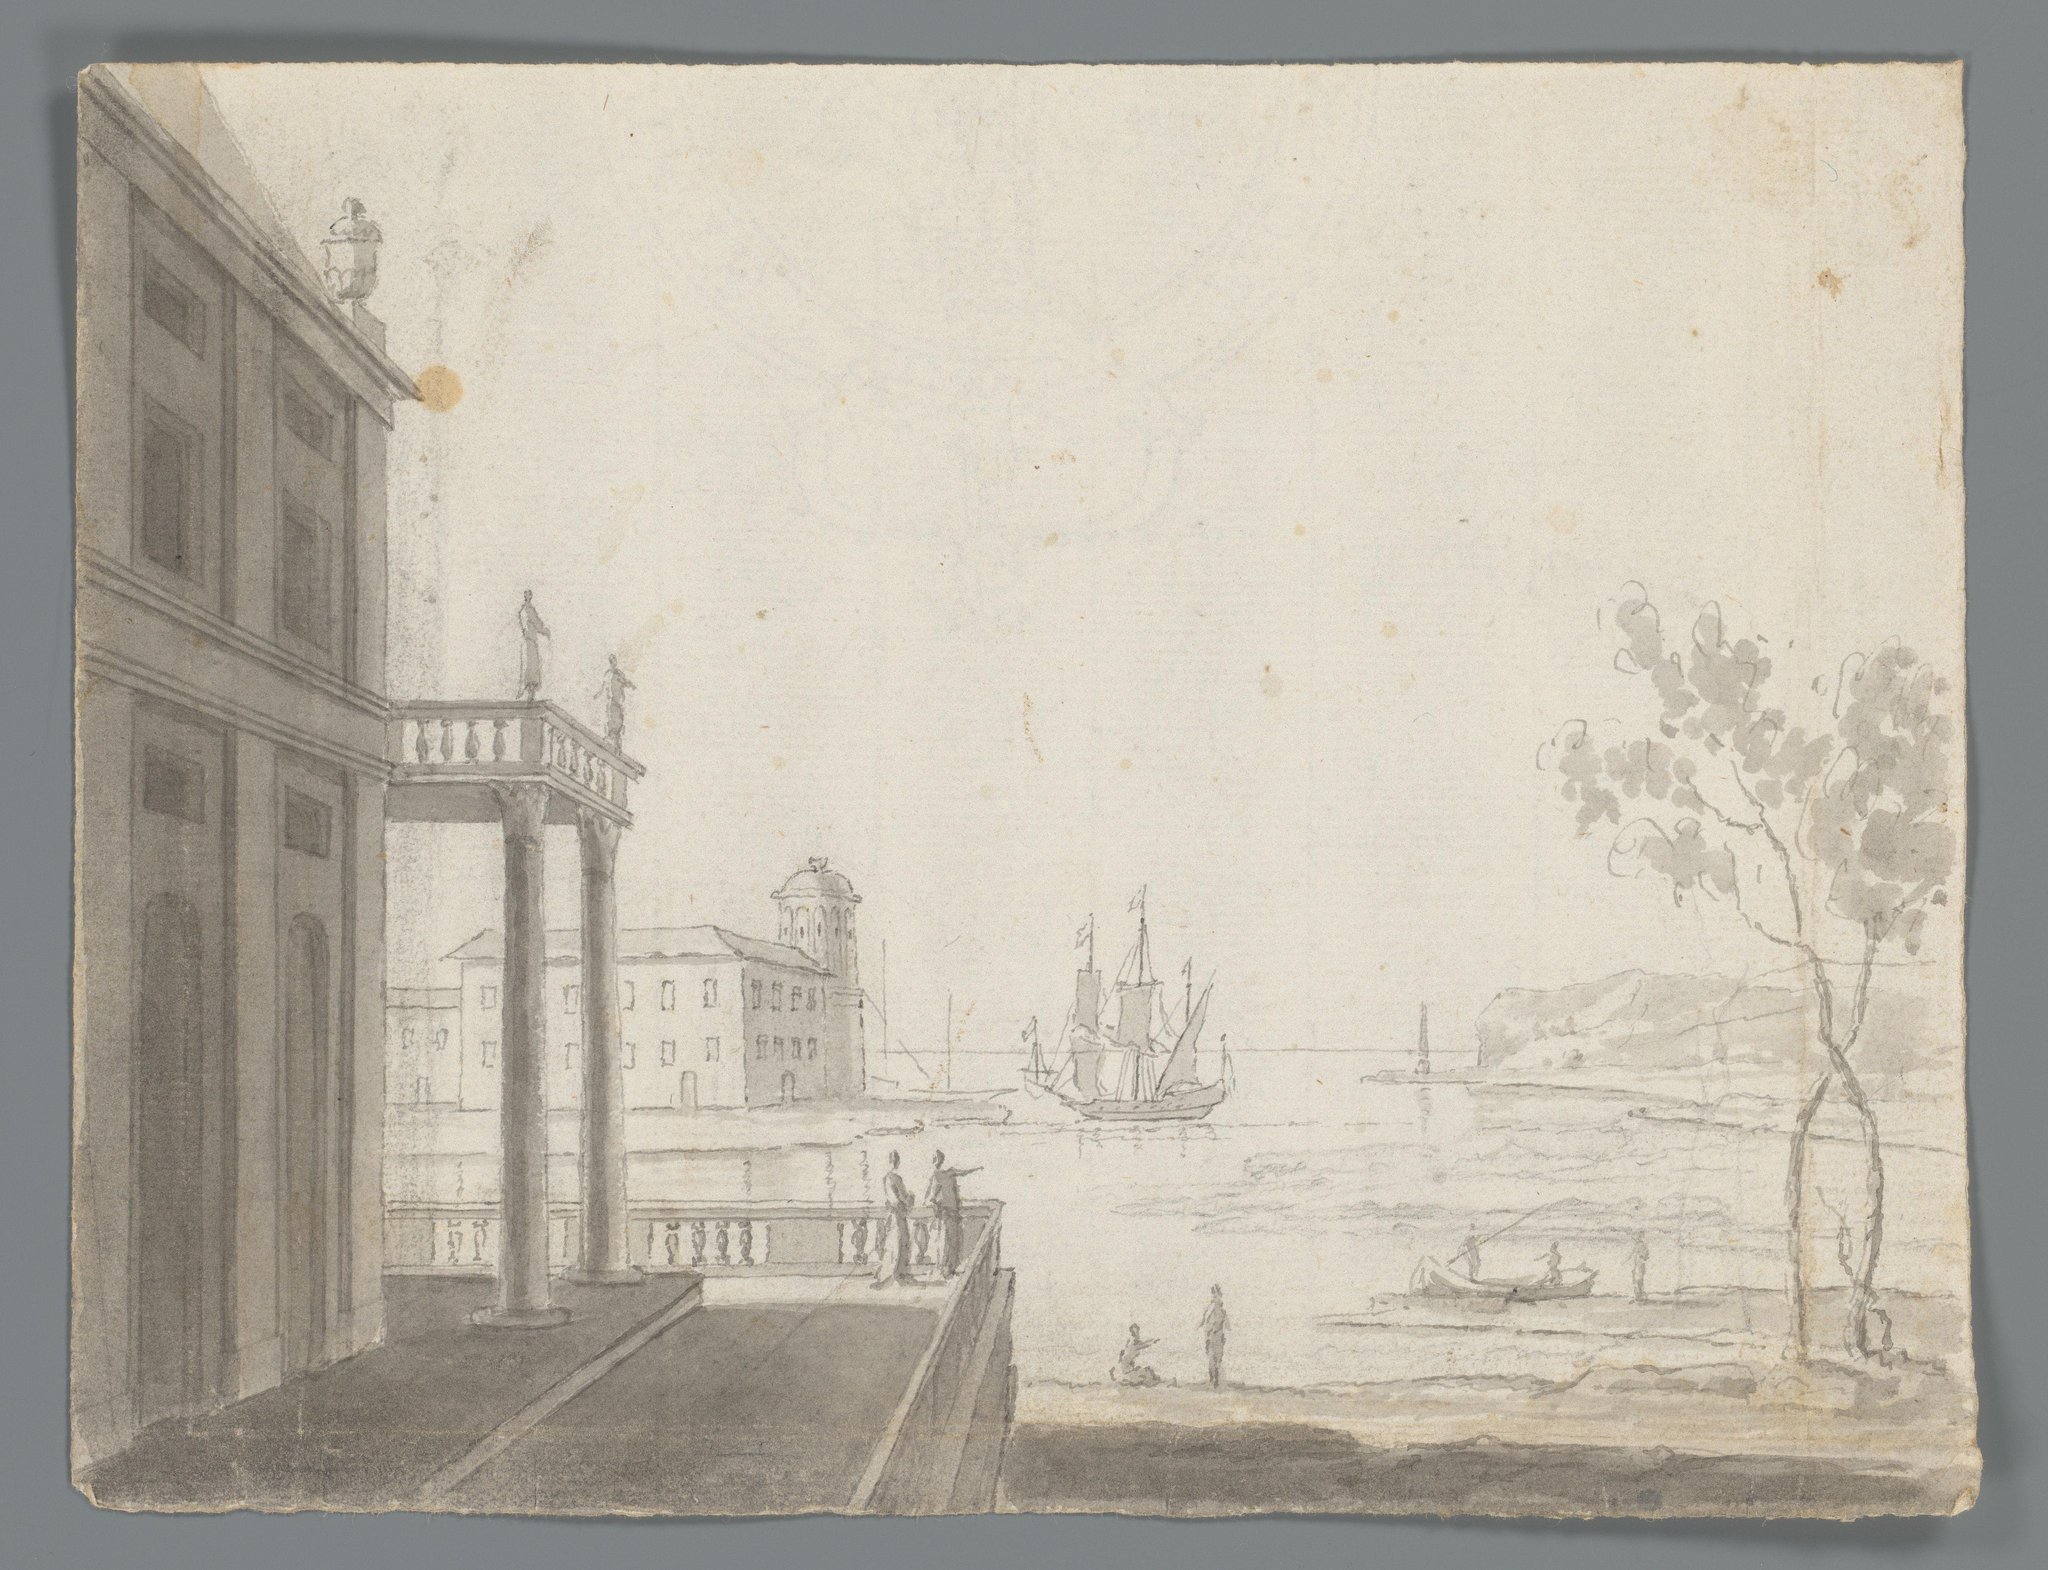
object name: drawing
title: Gebouw en terras aan het water met zicht op een driemaster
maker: matthijs balen (1684-1766)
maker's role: draughtsman, painter, print maker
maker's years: 1684-1766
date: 1694-1766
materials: paper, pencil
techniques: brush, pen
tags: city-view, and landscape with man-made constructions, ships (in general), terrace, civic architecture; edifices; dwellings